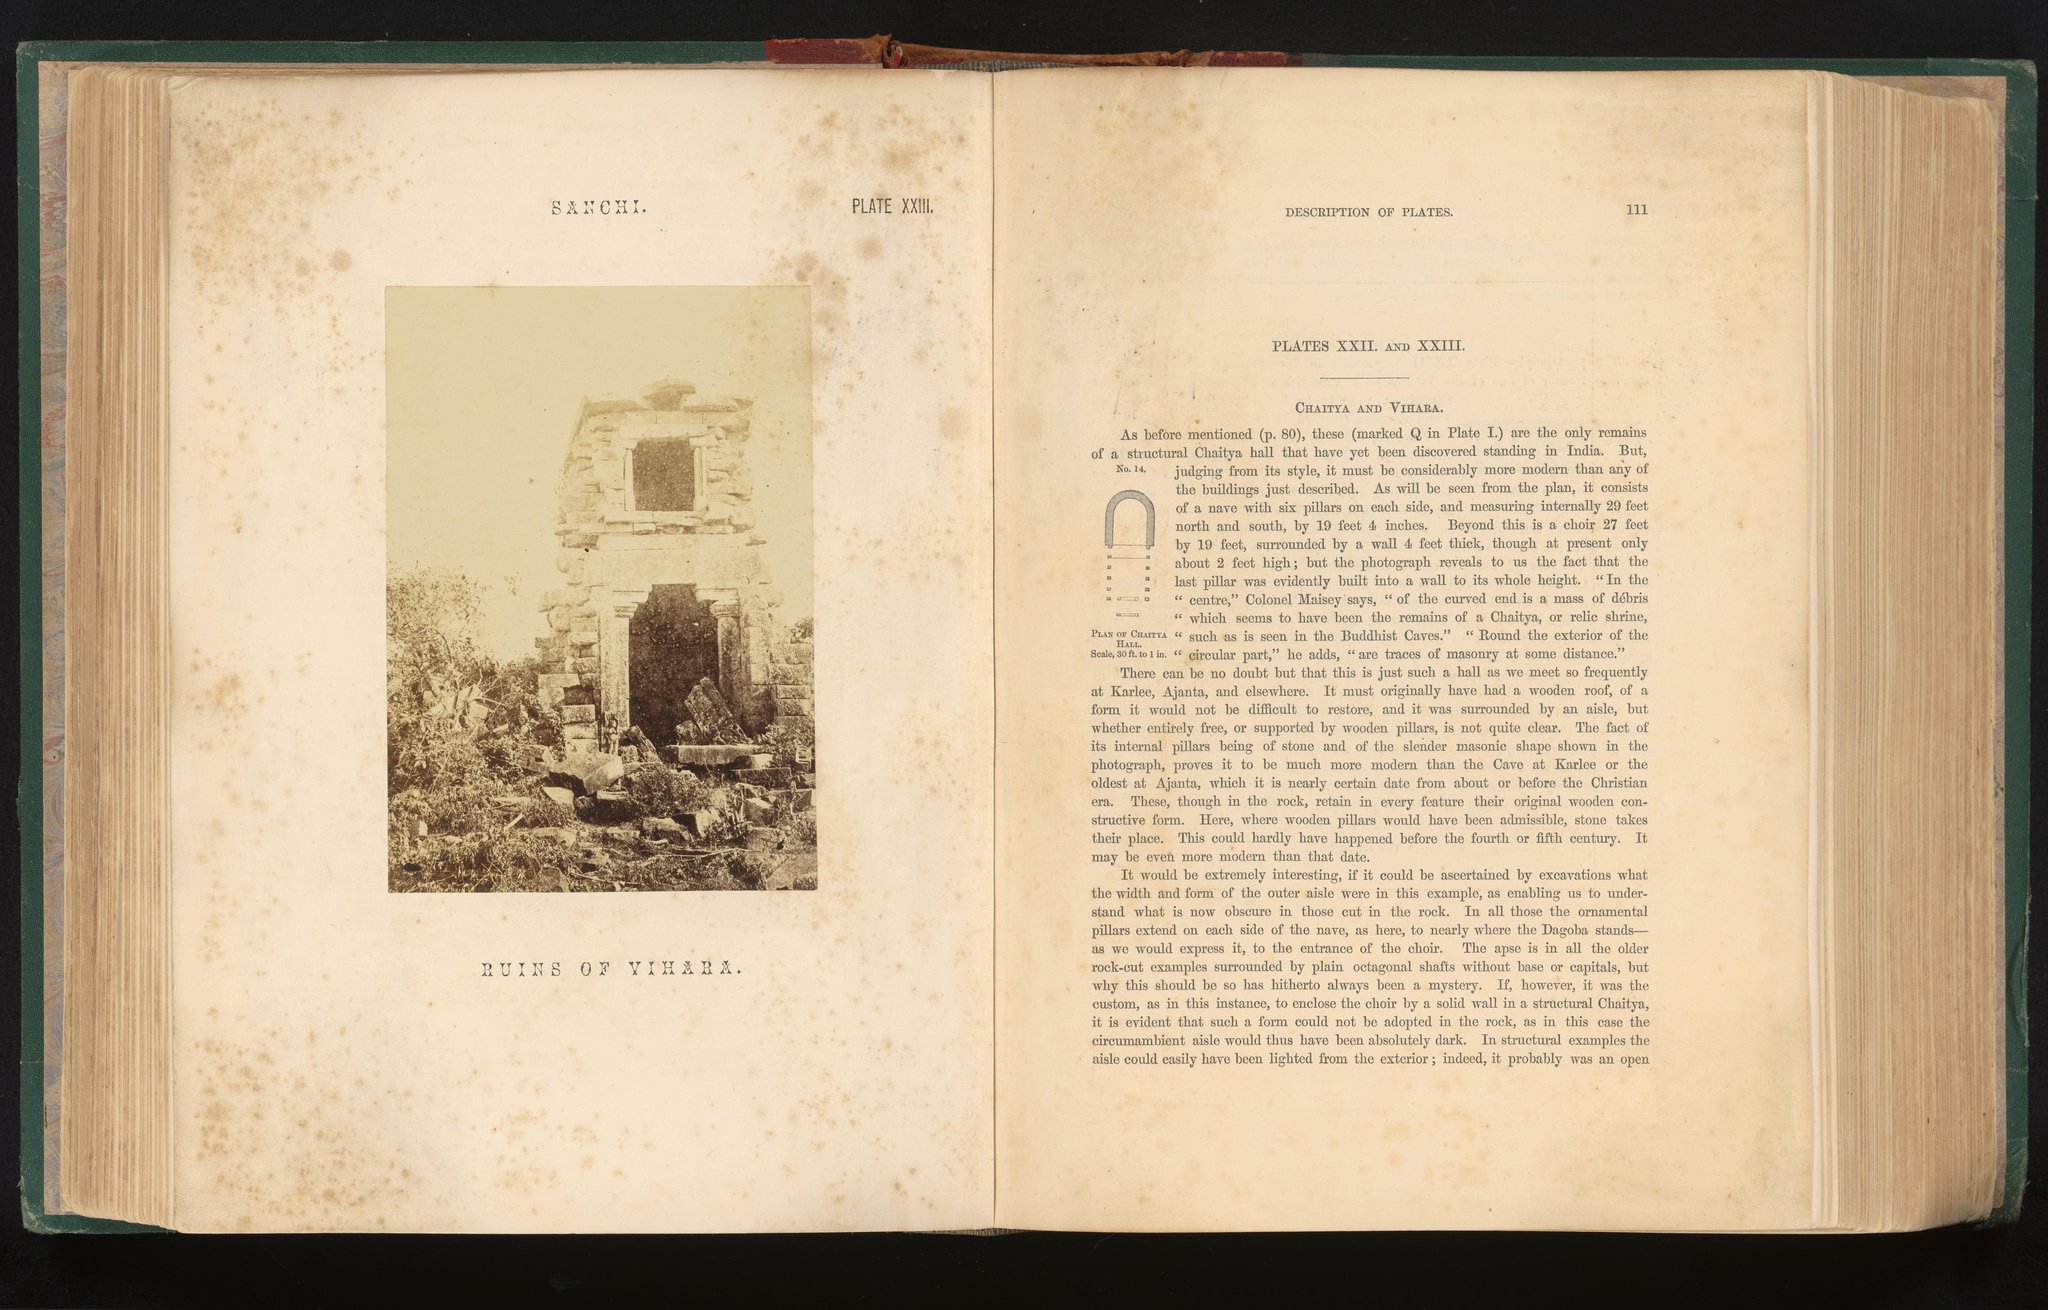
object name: page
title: Ruins of a vihara at Sanchi, Madhya Pradesh, India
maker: james john waterhouse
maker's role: fotograaf, luitenant, officier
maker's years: 1842-1928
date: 1863-1868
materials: photographic support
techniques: albumen print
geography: sanchi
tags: temple, shrine ~ hinduism, buddhism, jainism, landscape with ruins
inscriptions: inscription: ‘SANCHI. PLATE XXIII./ RUINS OF VIHARA.’